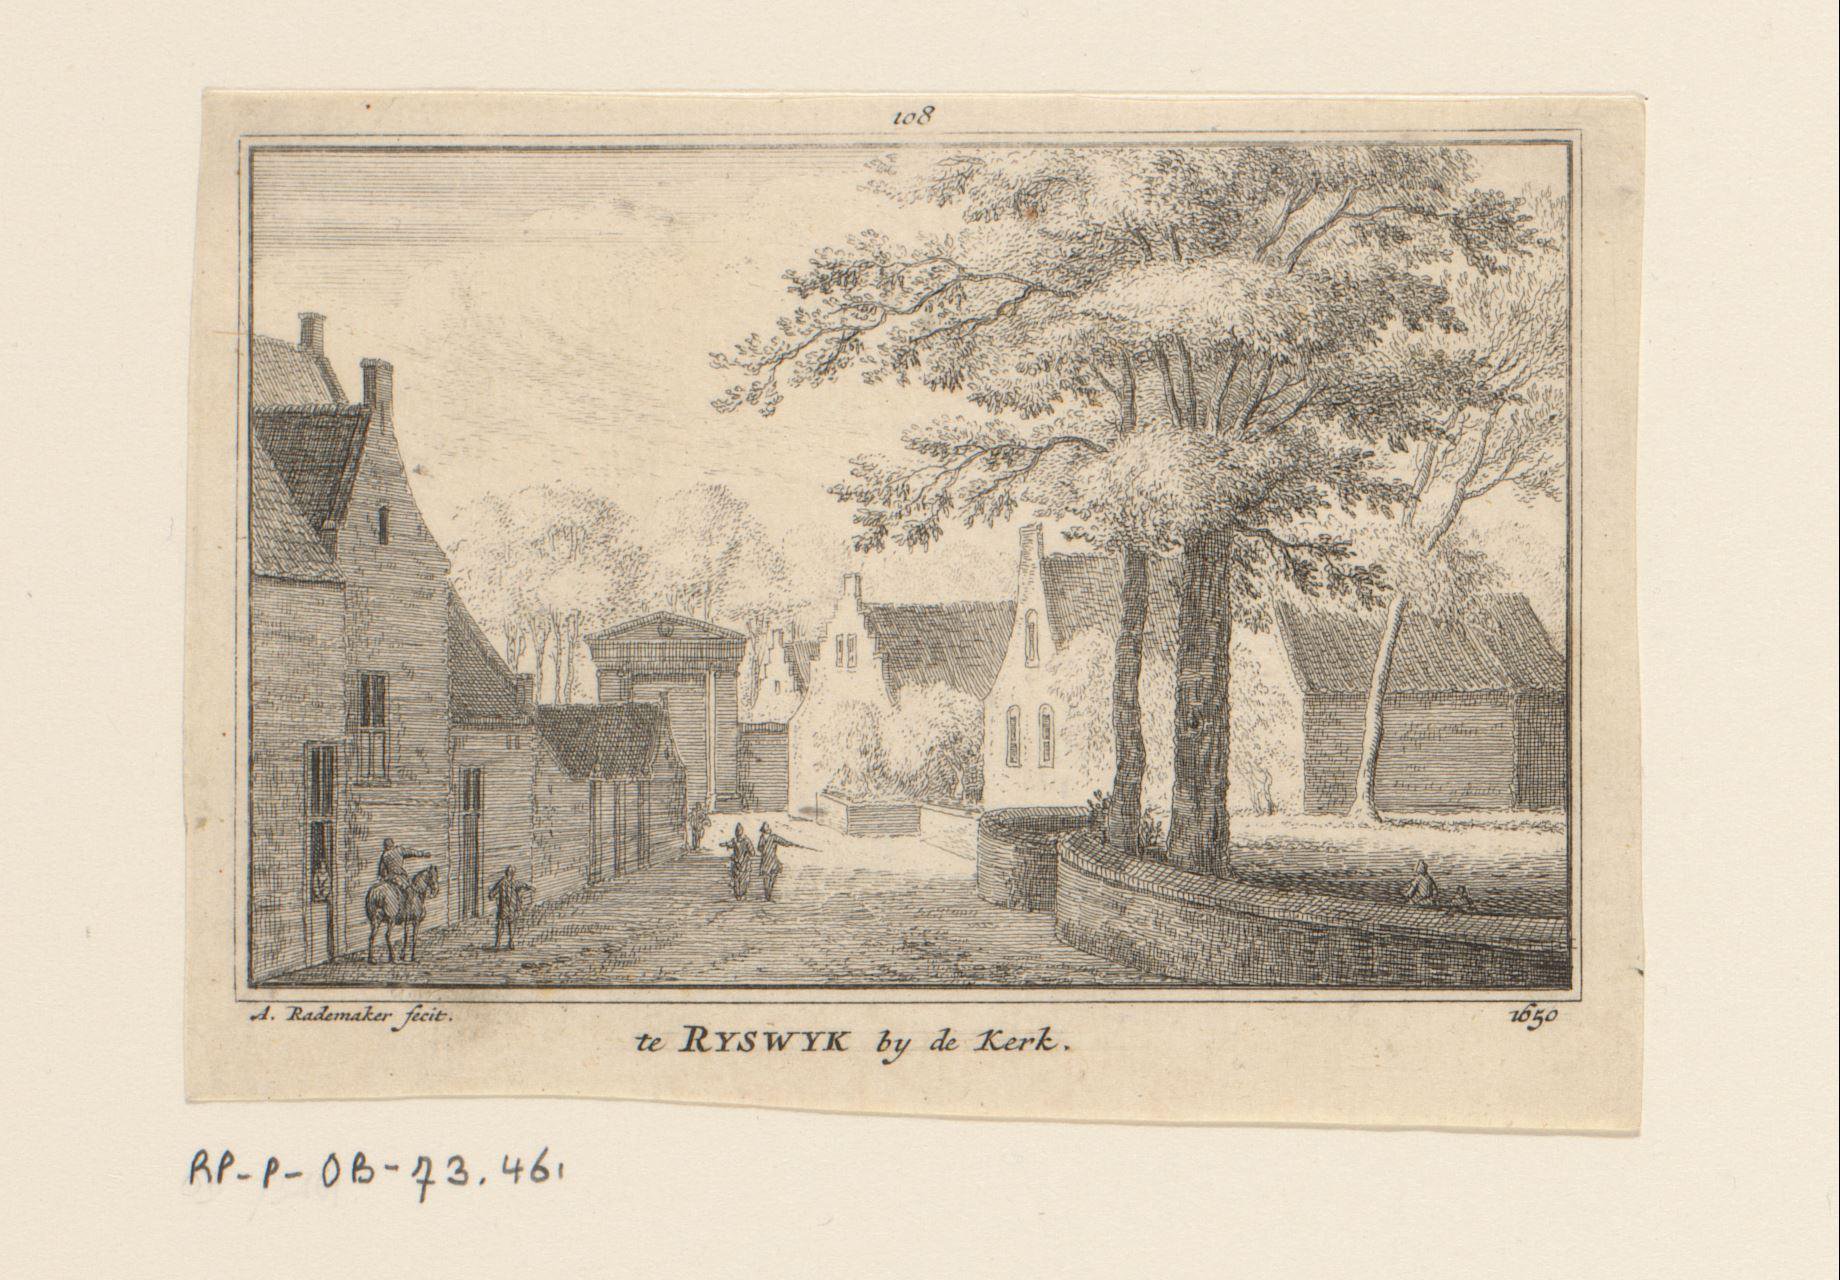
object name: book illustration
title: Gezicht te Rijswijk, 1650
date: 1727-1733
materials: paper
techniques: etching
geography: amsterdam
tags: riding a horse, ass, or mule; rider, horseman, village street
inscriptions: collector's mark: Lugt 2228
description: Illustratie uit: Abraham Rademaker, Matthaeus Brouërius van Niedek, Isaac Le Long, Kabinet van Nederlandsche en Kleefsche outheden en (...) voorname stads- en landgebouwen, Willem Barents en Antoni Schoonenburg: Amsterdam, 1727-1733, ill. nr. 108.